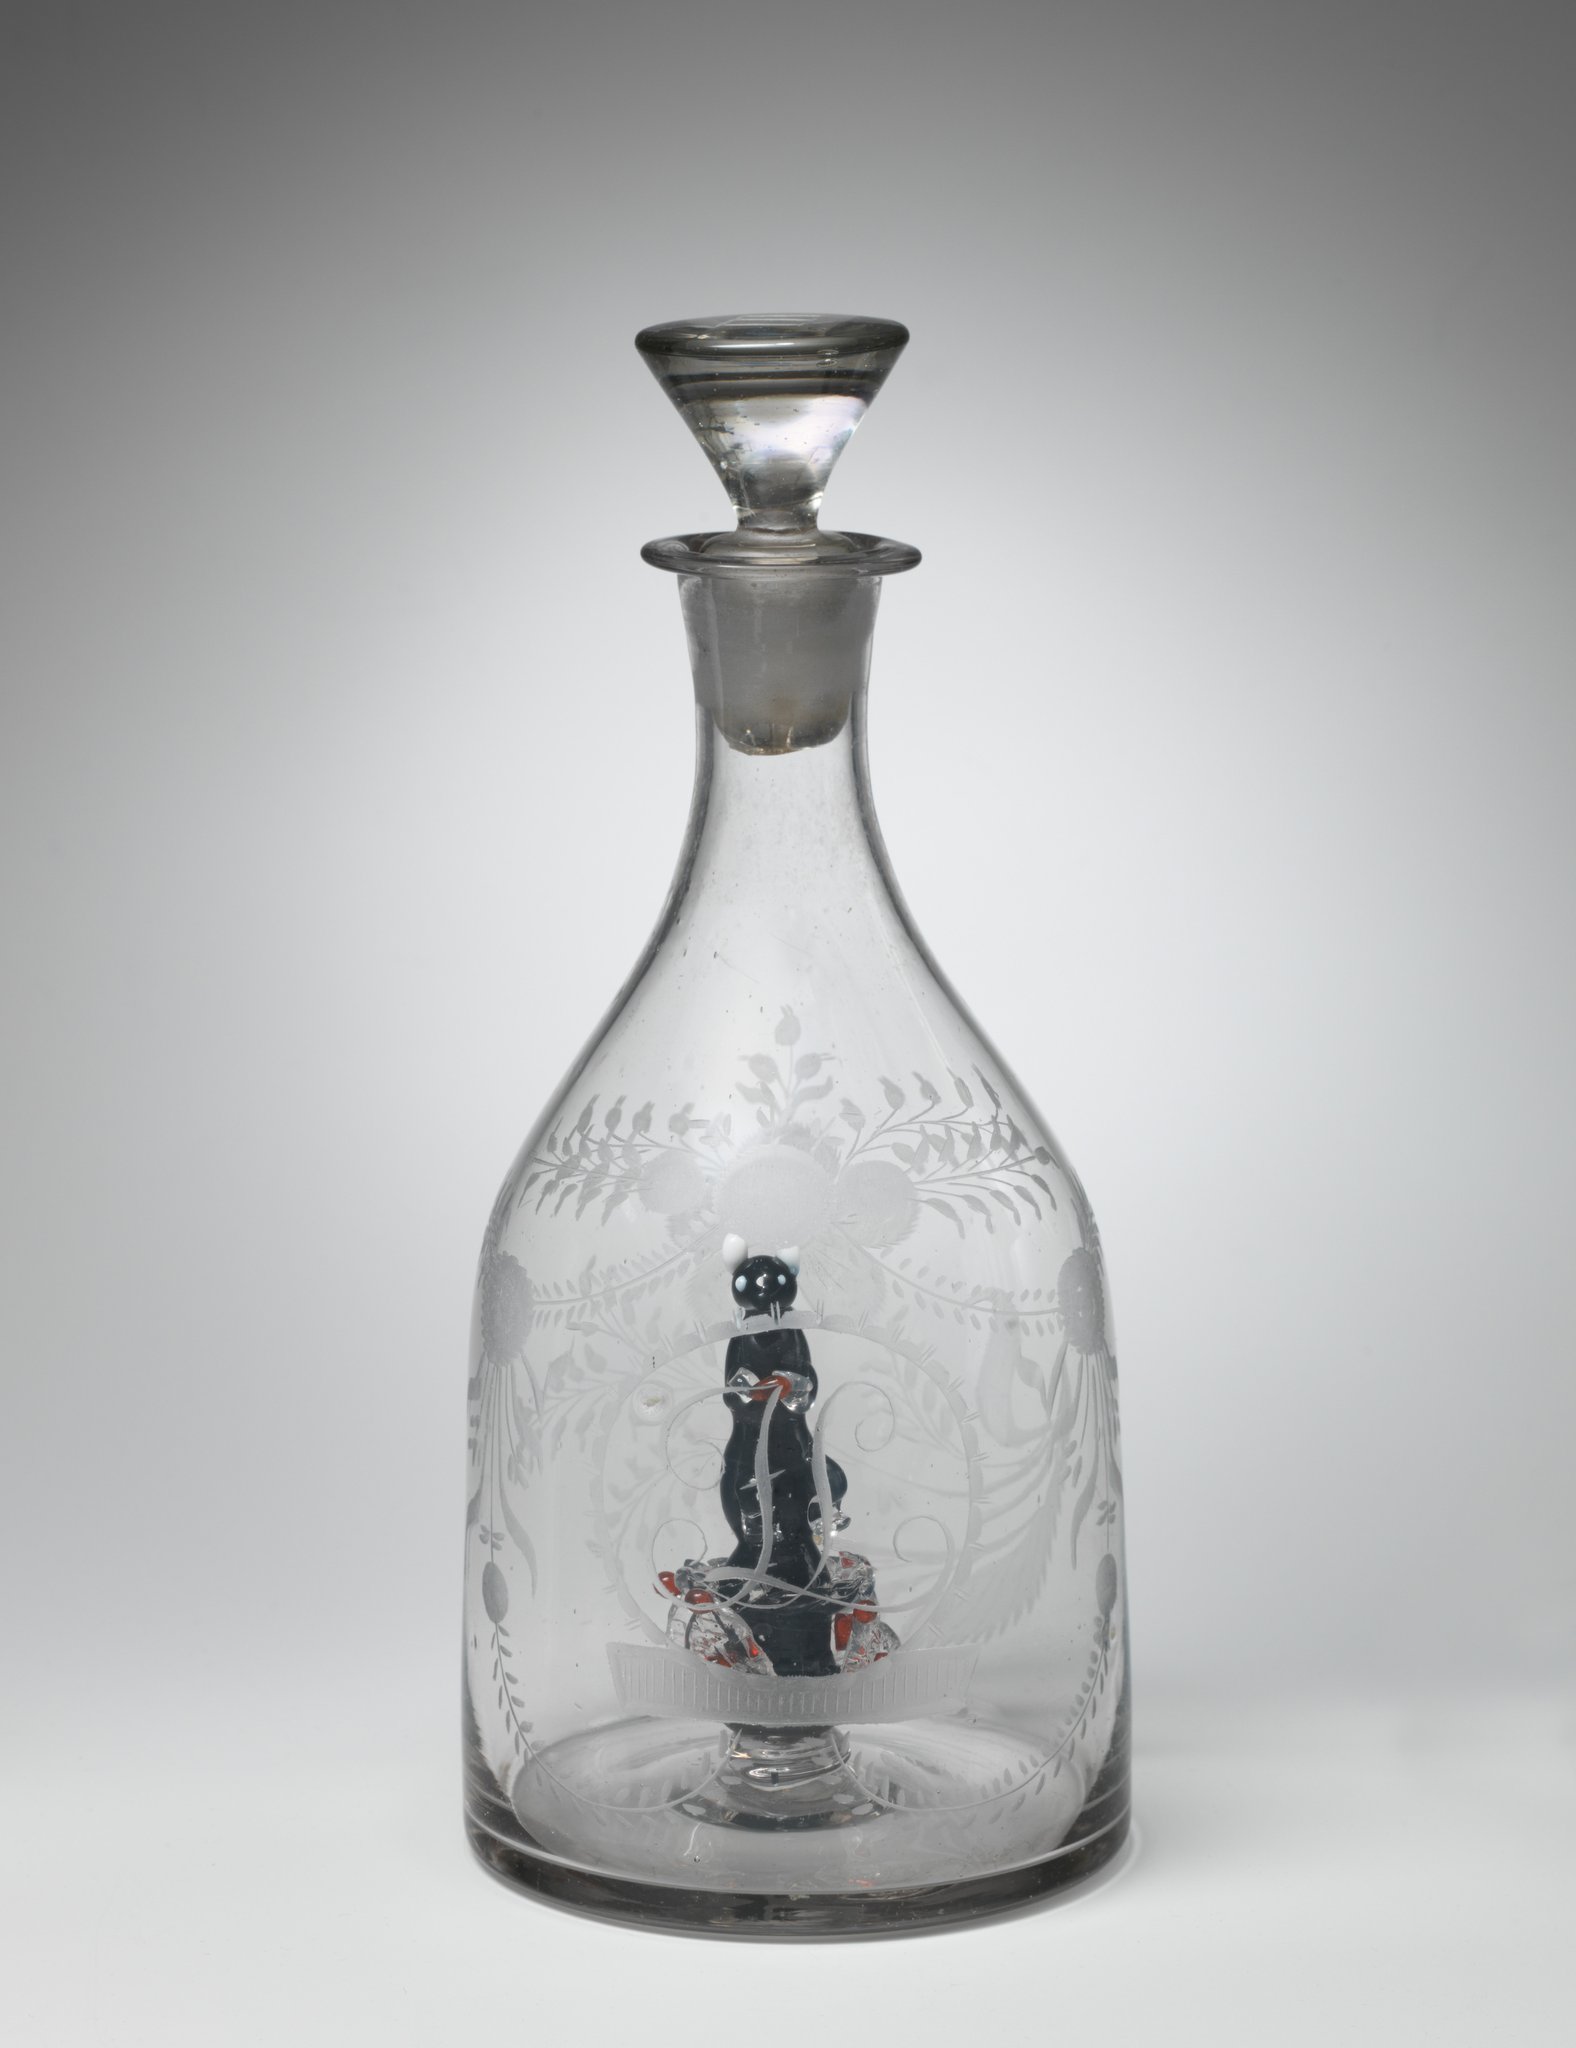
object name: decanter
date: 1801-1833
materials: glass